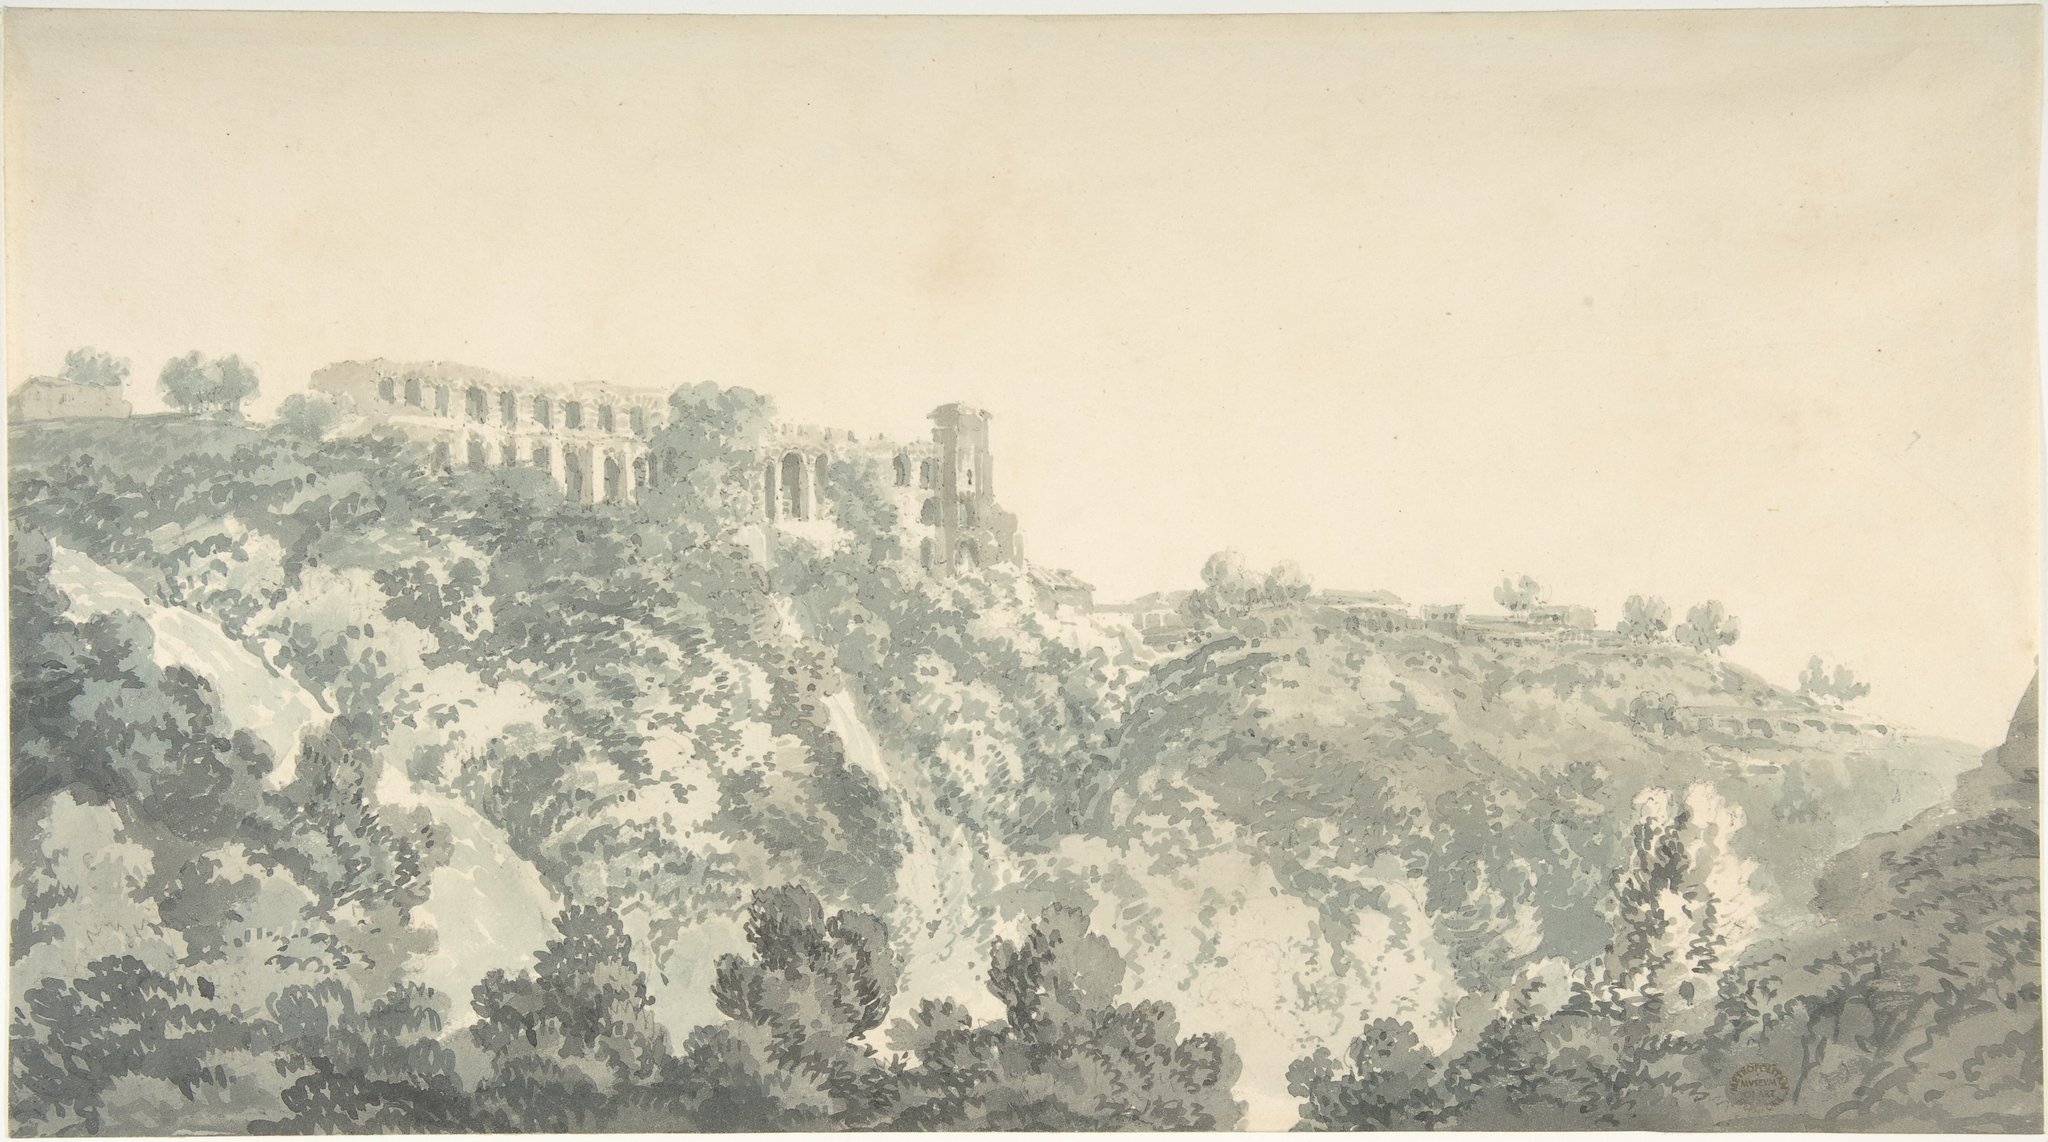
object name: drawing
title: Tivoli, Villa of Maecenas and part of the Cascatelle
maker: joseph mallord william turner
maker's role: artist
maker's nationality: british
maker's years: 1775-1851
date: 1794-1797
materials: graphite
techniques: brush, wash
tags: hills,landscapes,rome